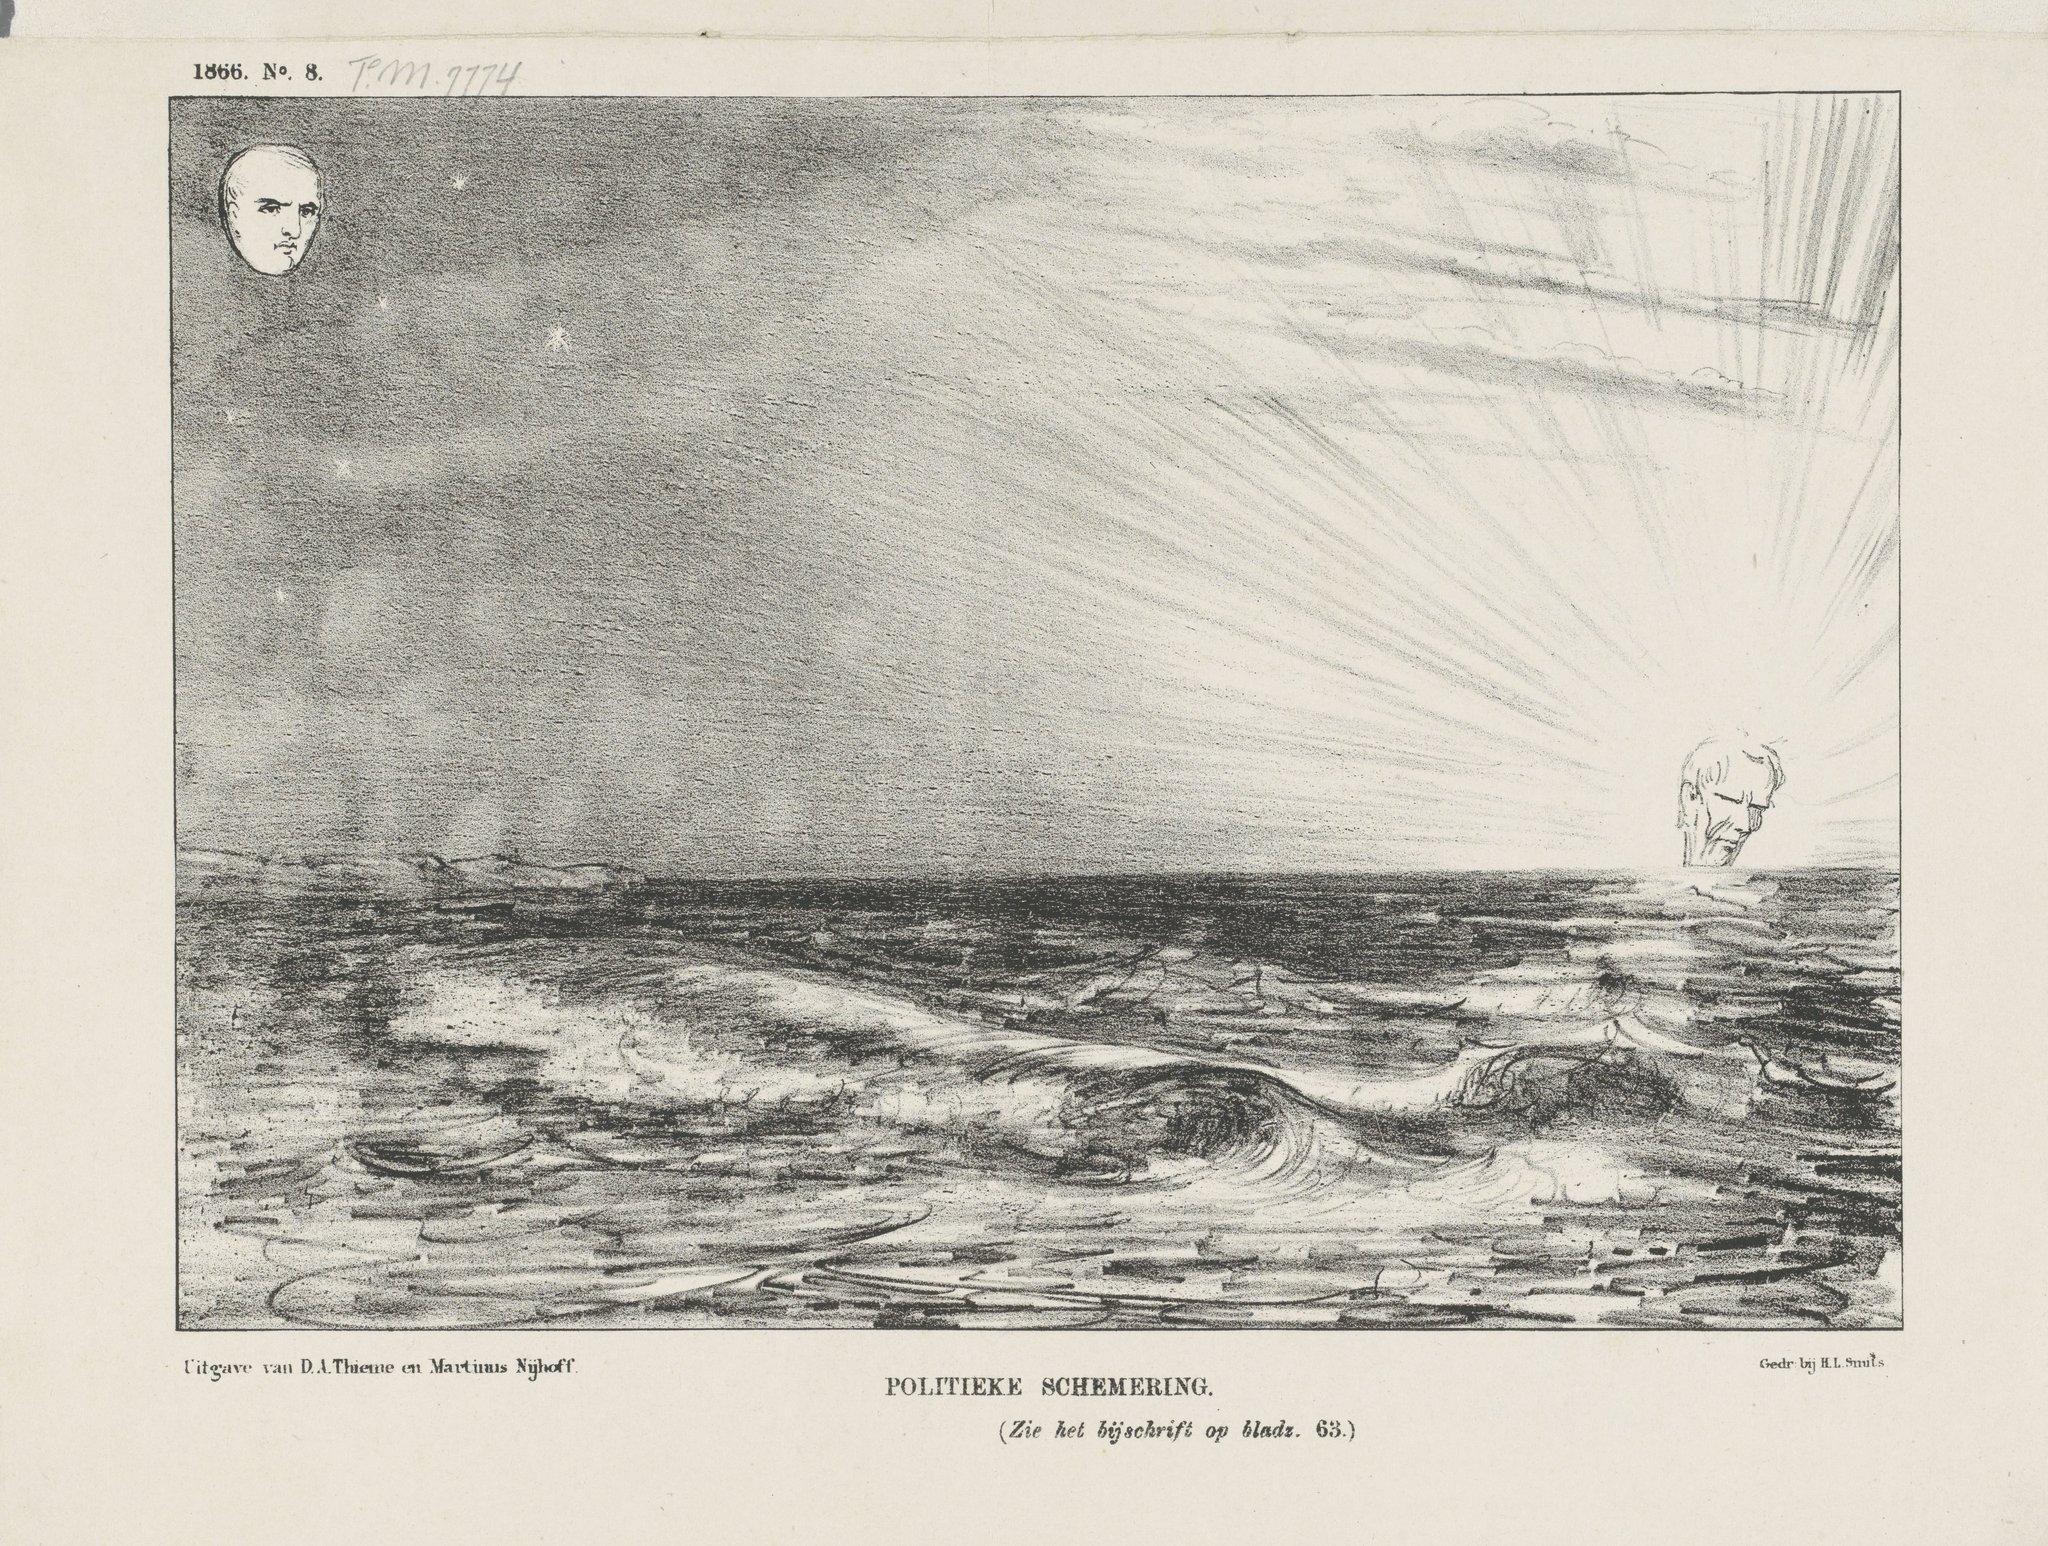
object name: cartoon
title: Politieke schemering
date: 1866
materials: paper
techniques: lithograph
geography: arnhem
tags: the hague, johan rudolf thorbecke, sunset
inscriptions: collector's mark: Lugt 2228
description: Spotprent naar aanleiding van het aftreden van Thorbecke en het aantreden van Fransen van de Putte. Thorbecke als de zon die ondergaat in de zee met Fransen van de Putte als maan aan de hemel. Plaat verschenen bij het weekblad De Nederlandsche Spectator, nr. 8, 24 februari 1866.